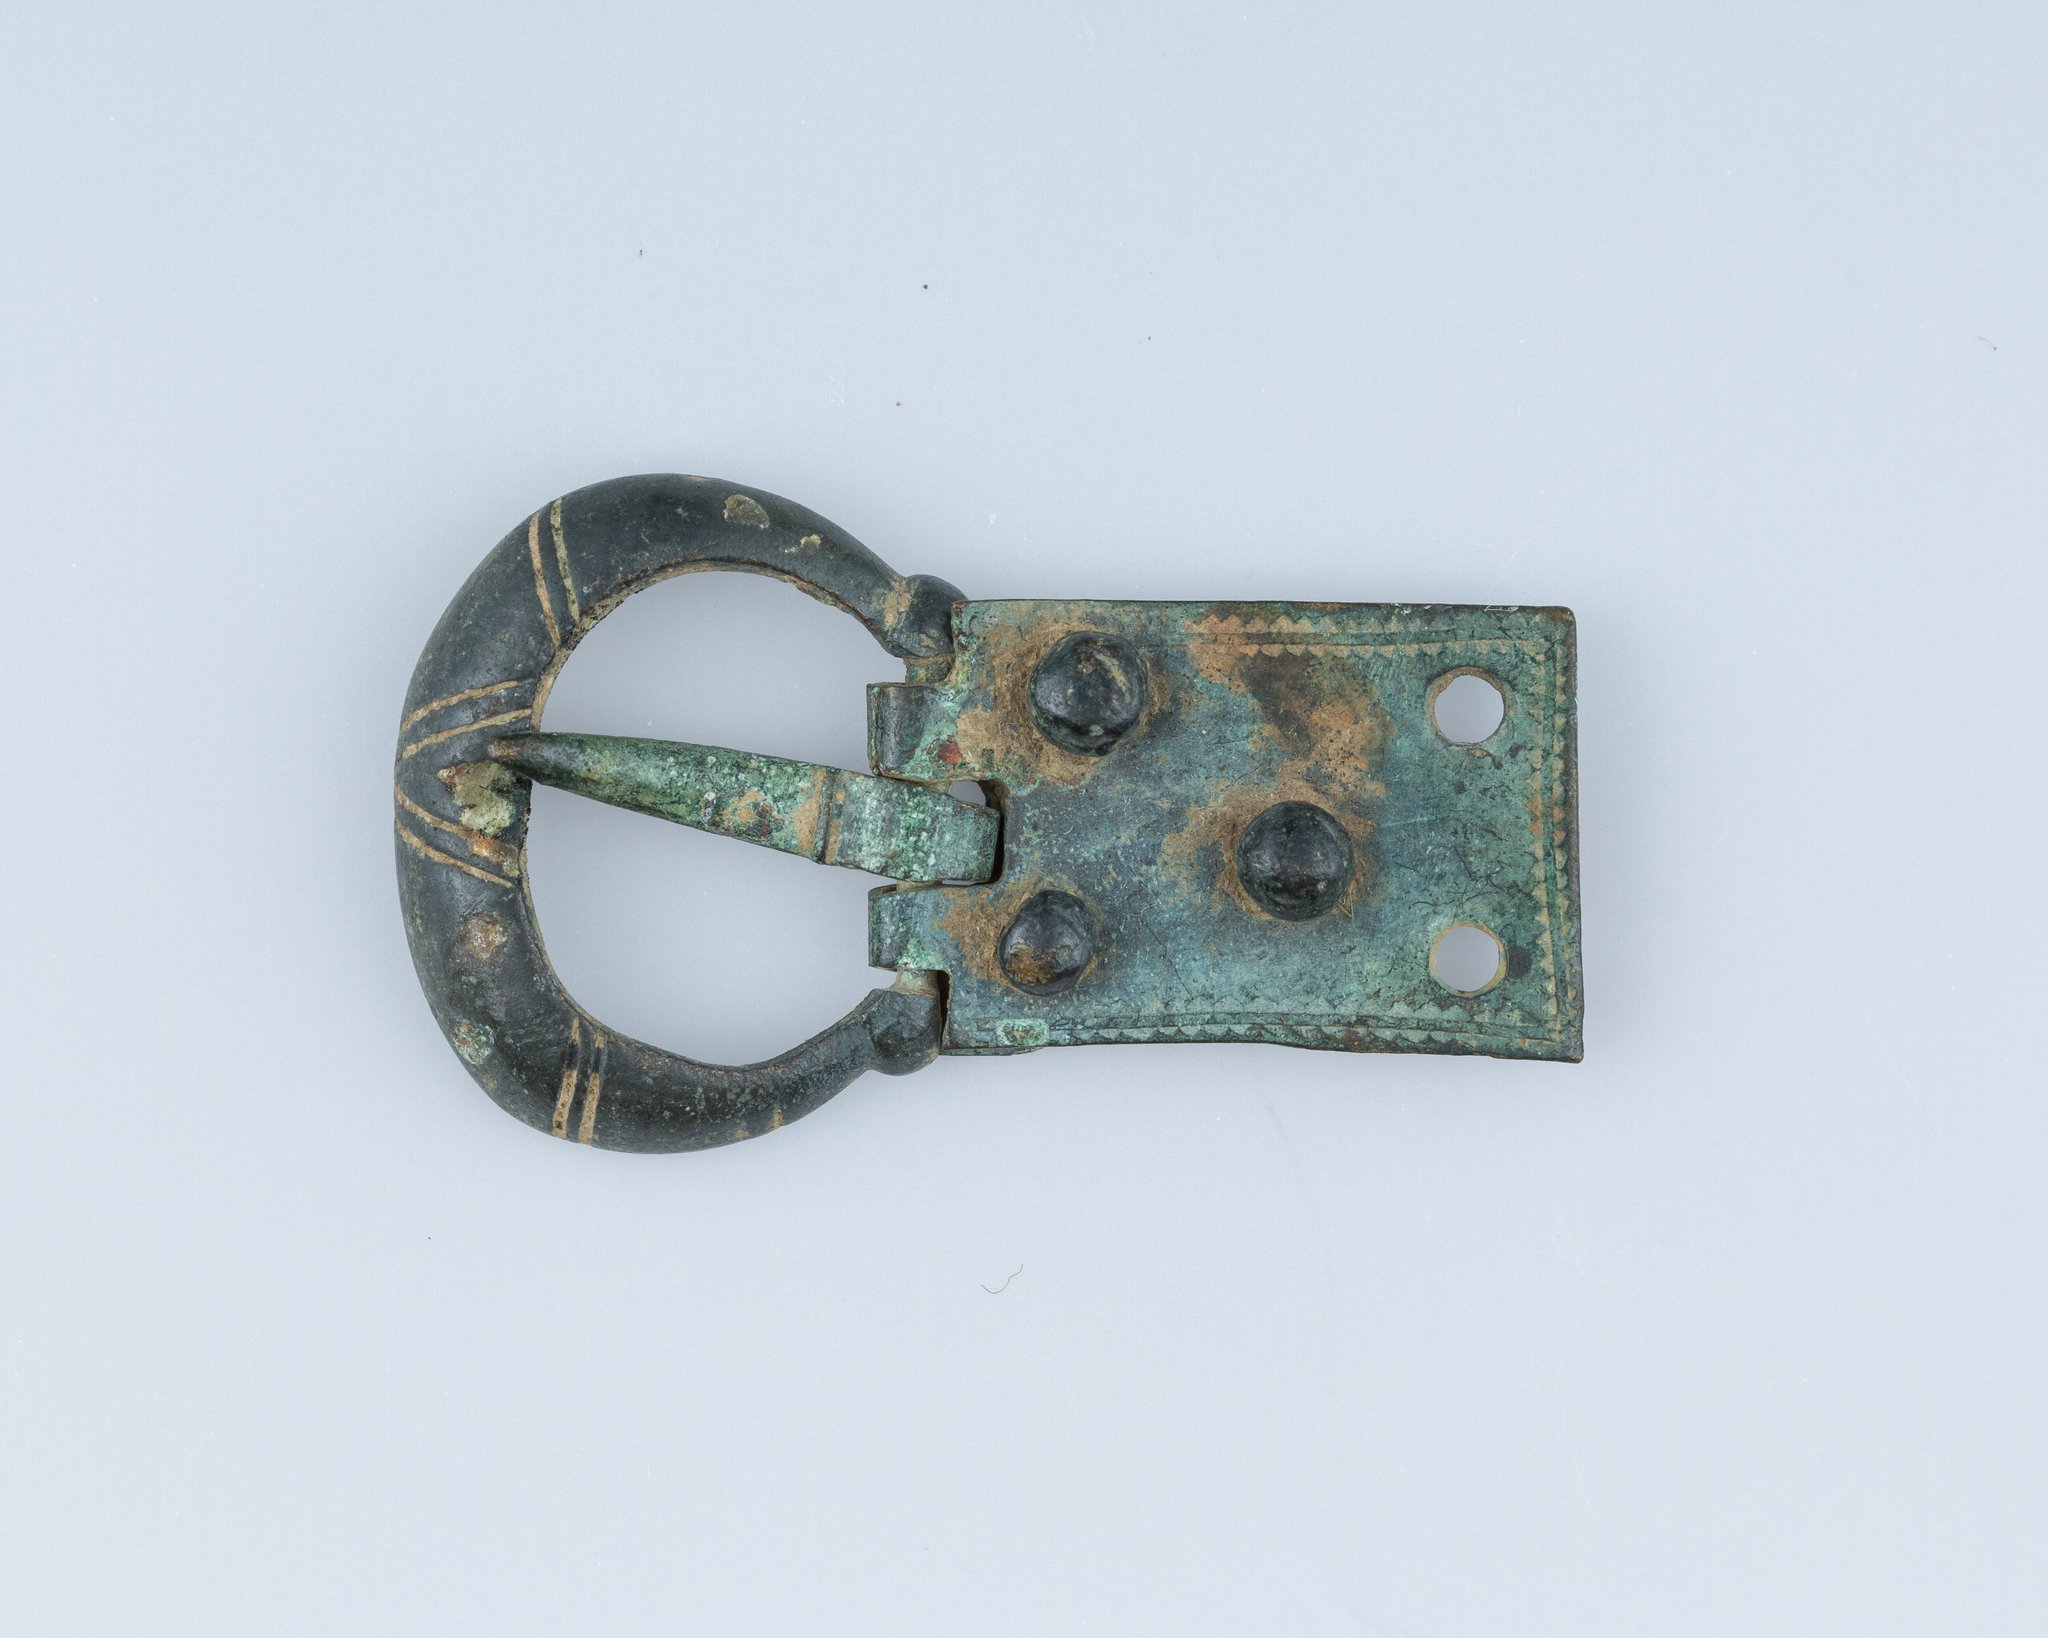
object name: buckle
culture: french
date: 1101-1200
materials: bronze, patina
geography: france